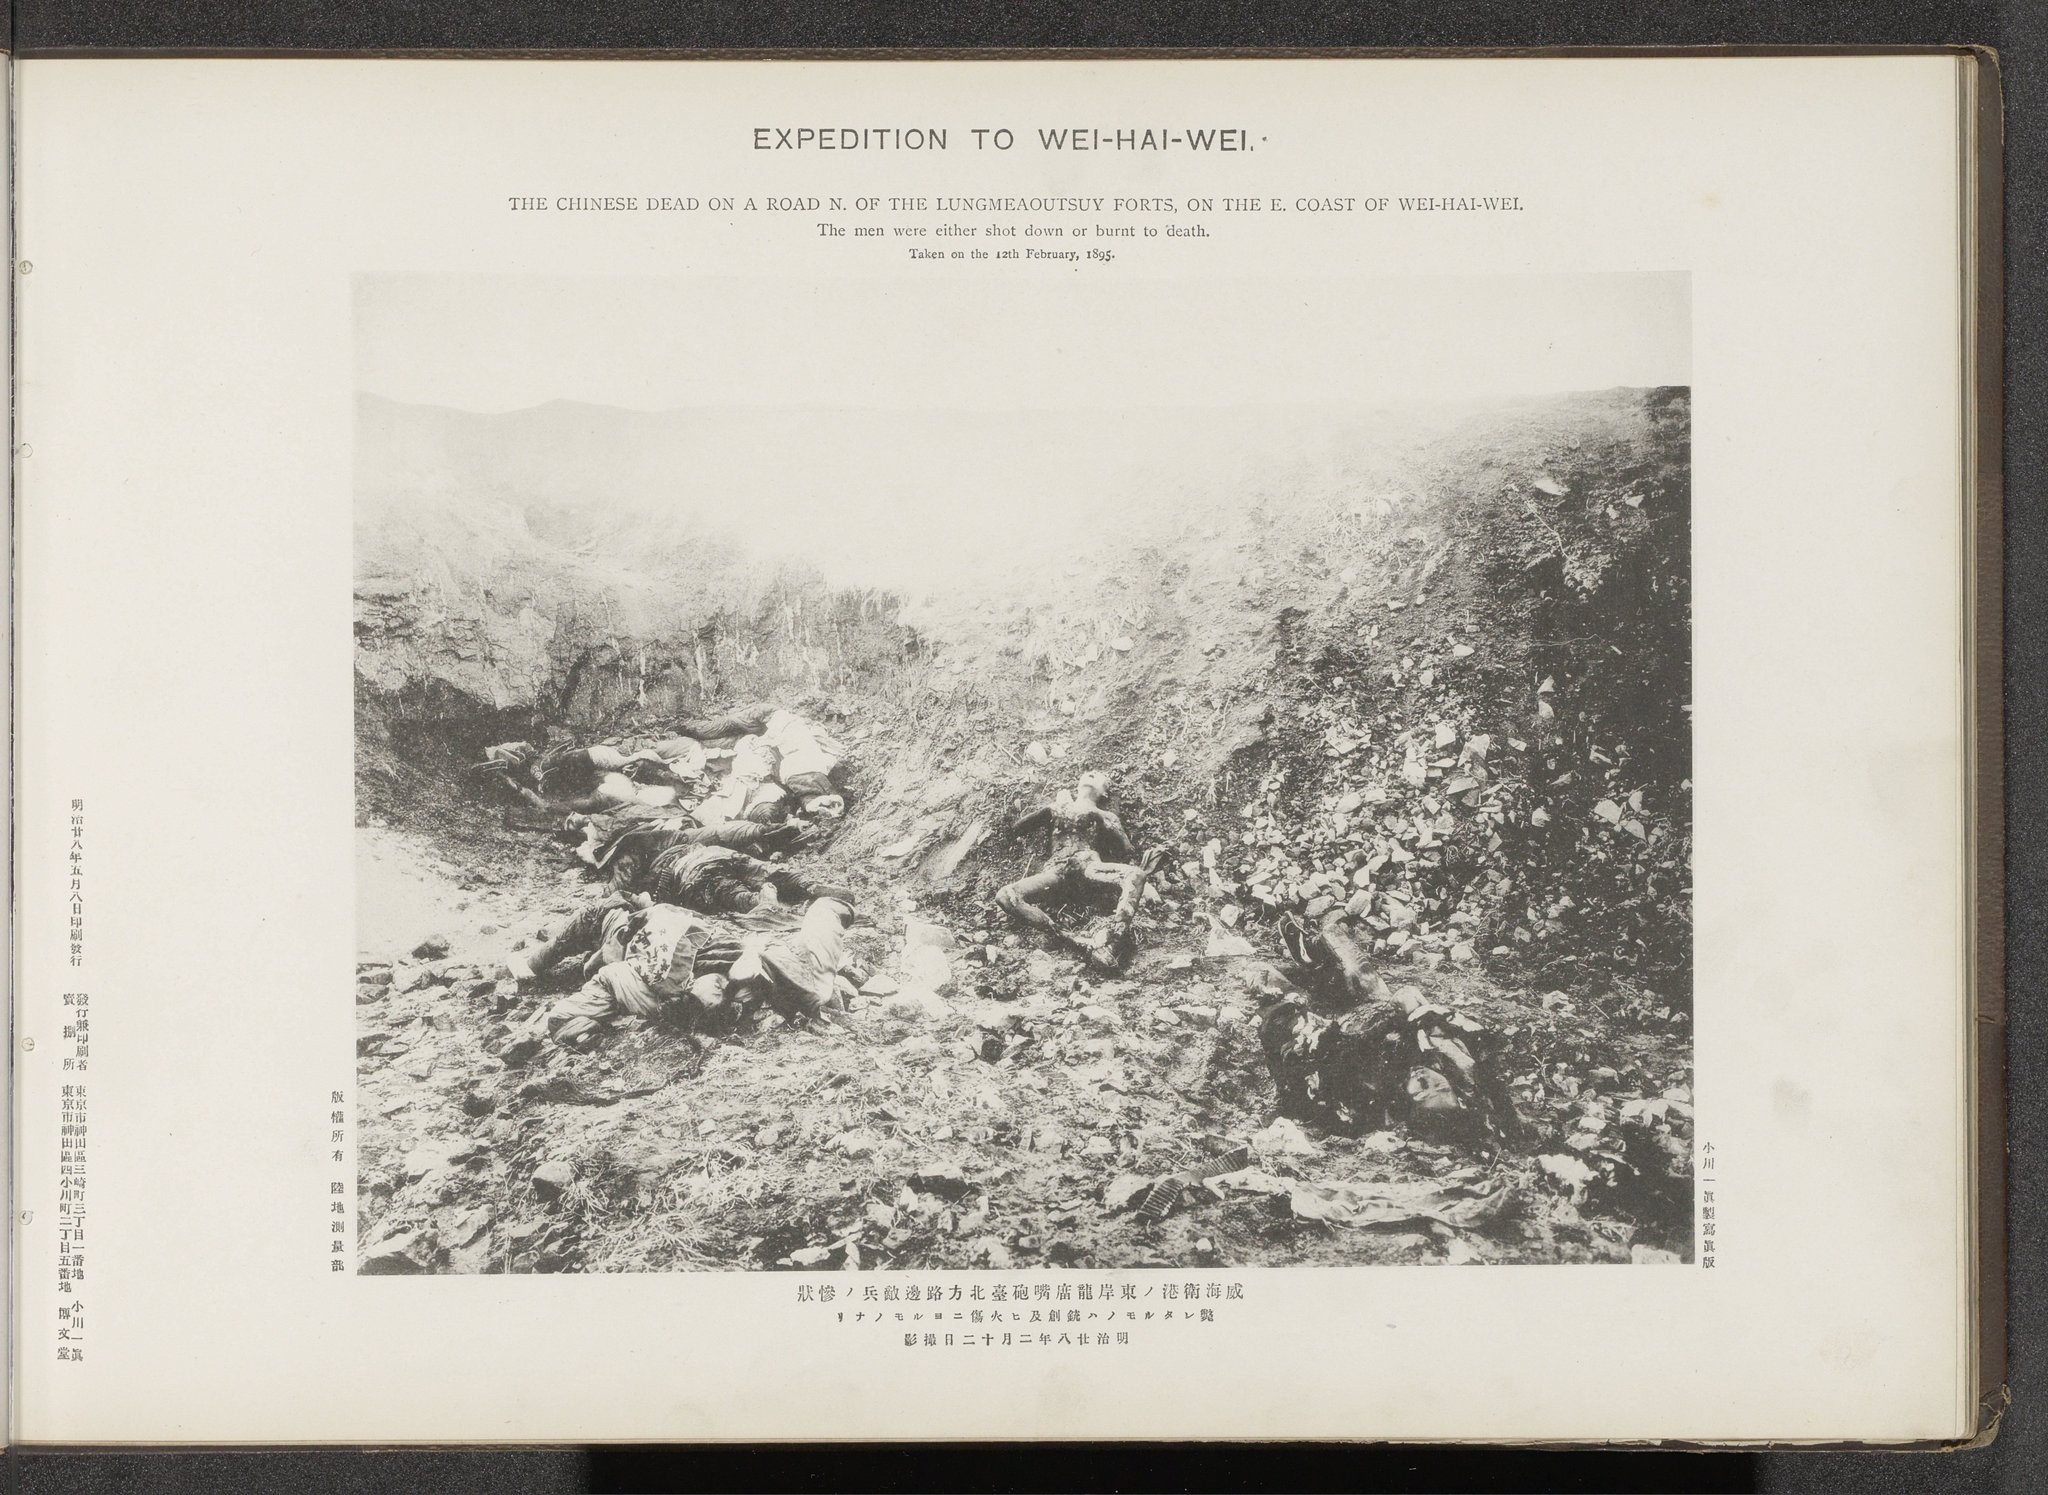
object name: page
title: The Chinese dead on a road N. of the Lungmeaoutsuy forts, on the E. Coast of Wei-Hai-Wei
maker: kazumasa ogawa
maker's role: auteur, fotograaf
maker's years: 1860-1929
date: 1895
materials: paper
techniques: photograph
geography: shandong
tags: the corpse, public road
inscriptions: inscription: ‘The men were either shot down or burnt to death.’, inscription: ‘Expedition to Wei-Hai-Wei.’